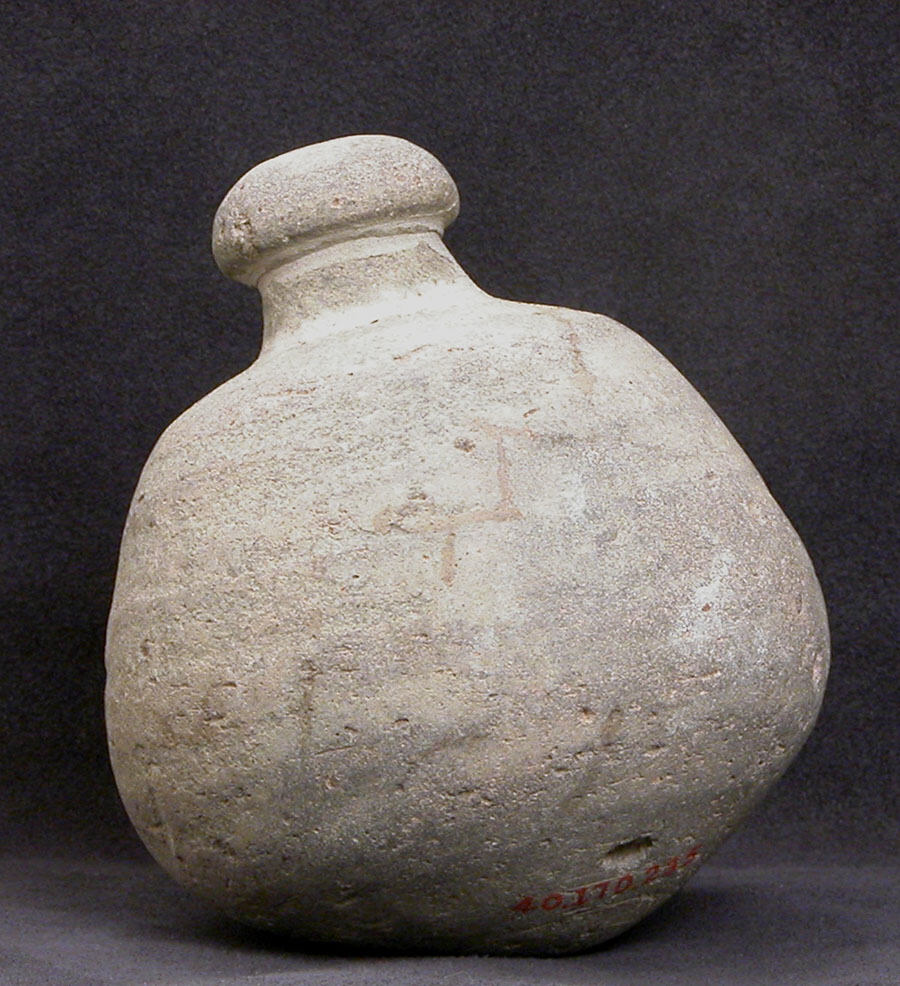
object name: vessel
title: Spheroconical Vessel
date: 801-1000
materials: earthenware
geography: iran